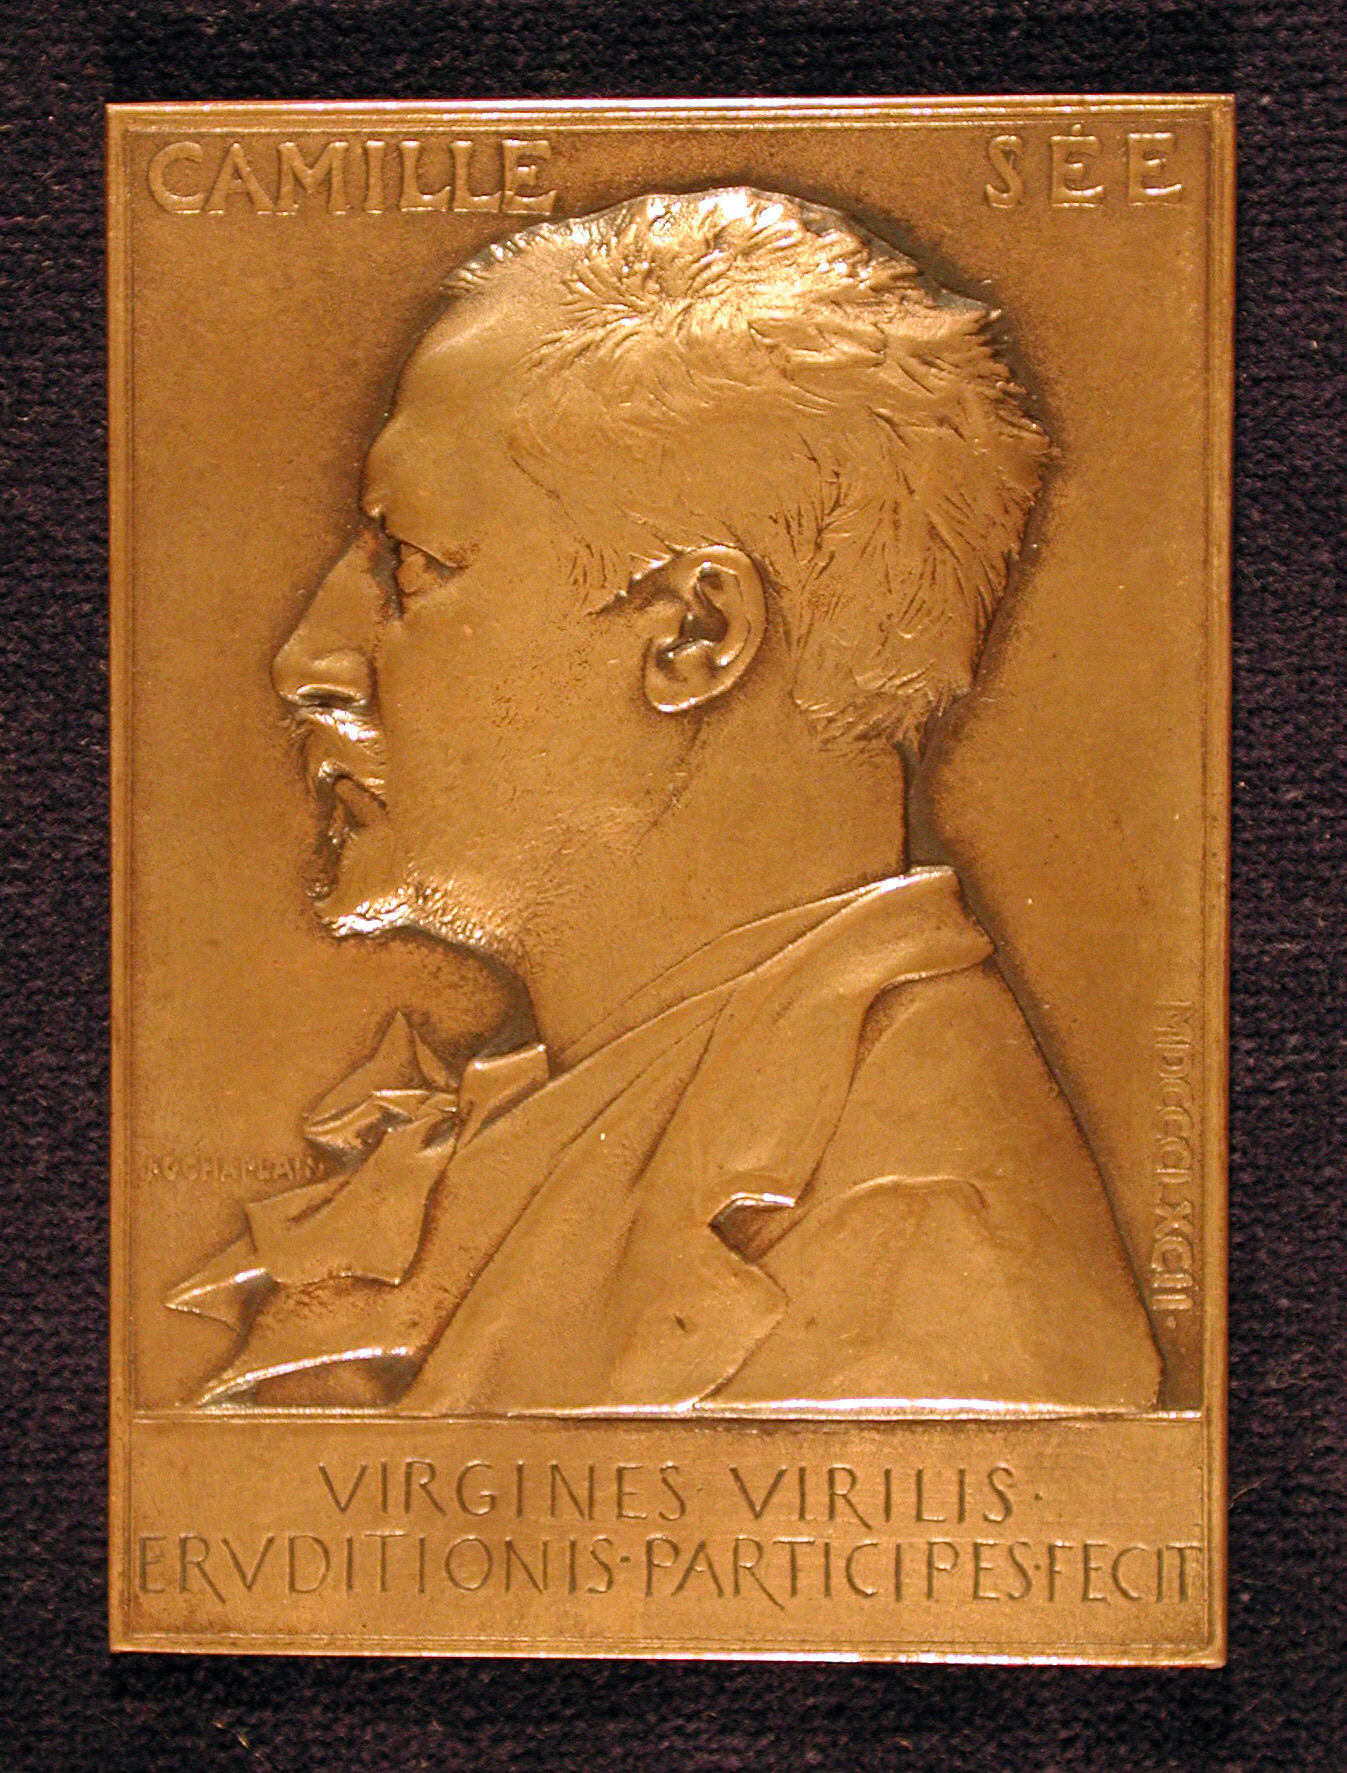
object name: medal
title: Camille Sée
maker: jules-clément chaplain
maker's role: artist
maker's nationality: french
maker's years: 1839-1909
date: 1892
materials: bronze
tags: men,profiles